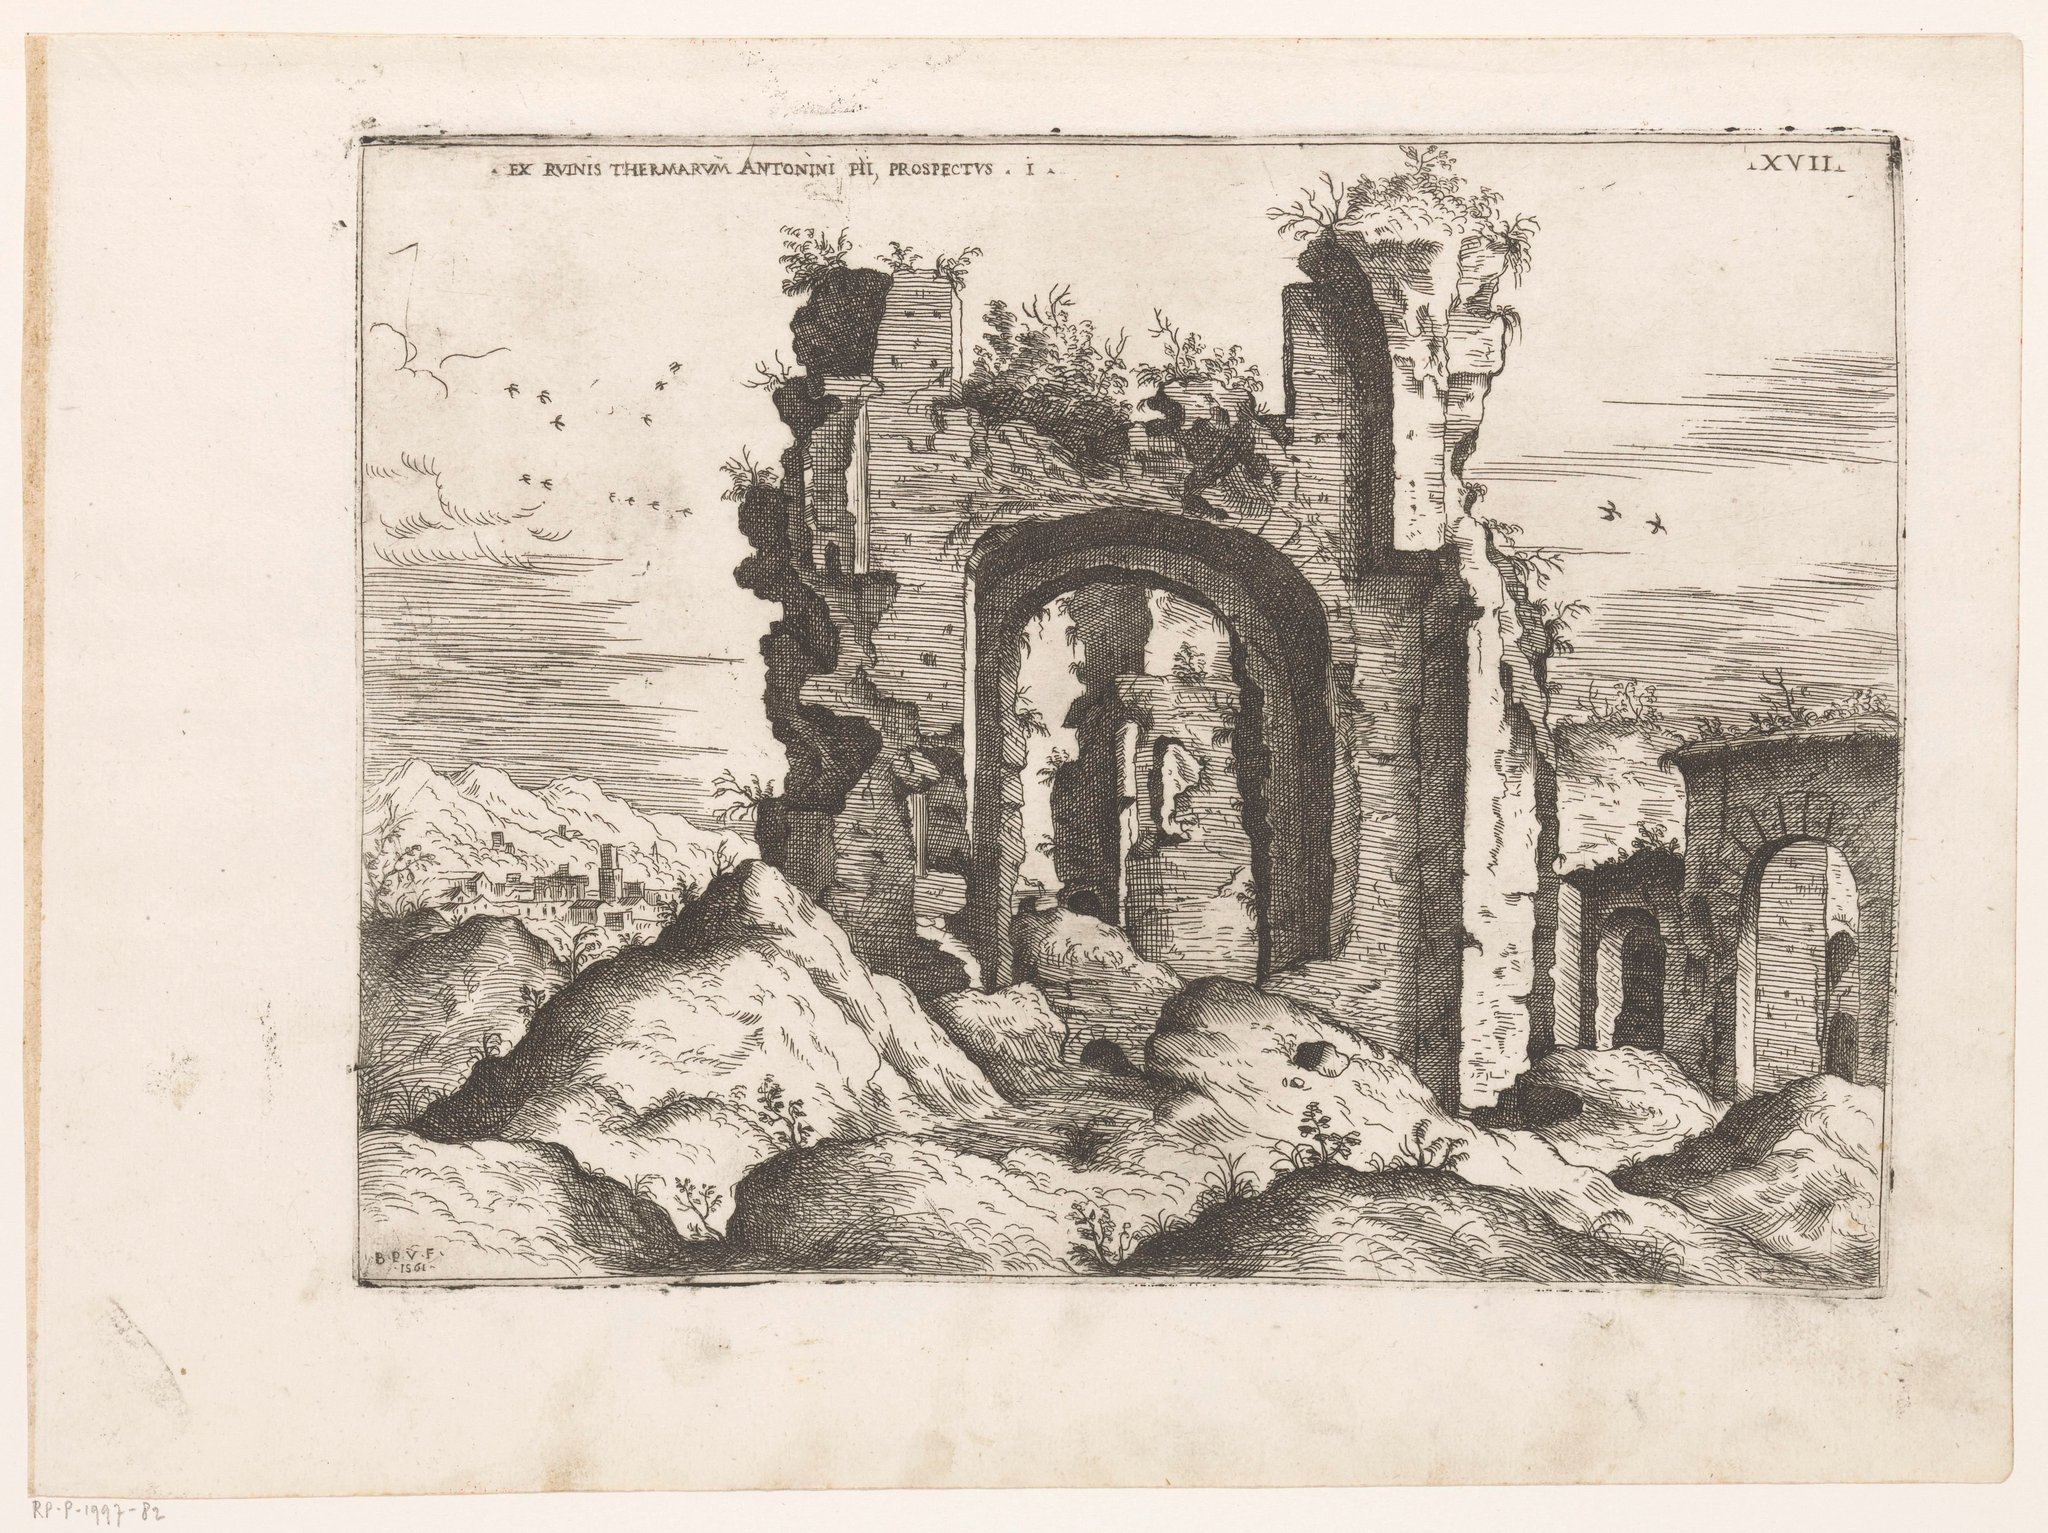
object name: book illustration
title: Praecipua aliquot Romanae Antiquitatis Ruinarum Monimenta (...)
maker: giovanni battista pittoni (i)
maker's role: print maker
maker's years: 1520-1583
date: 1561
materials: paper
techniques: etching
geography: vicenza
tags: ruin of a building ~ architecture, landscape with ruins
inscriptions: collector's mark: Lugt 2228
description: Deze prent maakt deel uit van een reeks illustraties voor het traktaat van Vincenzo Scamozzi 'Discorsi sopra le antichità di Roma', Venetië 1582. De prenten zijn vrije kopieën naar een serie prenten van Hieronymus Cocks die voor het eerst werd uitgegeven in 1551 (Hollstein 22-47).